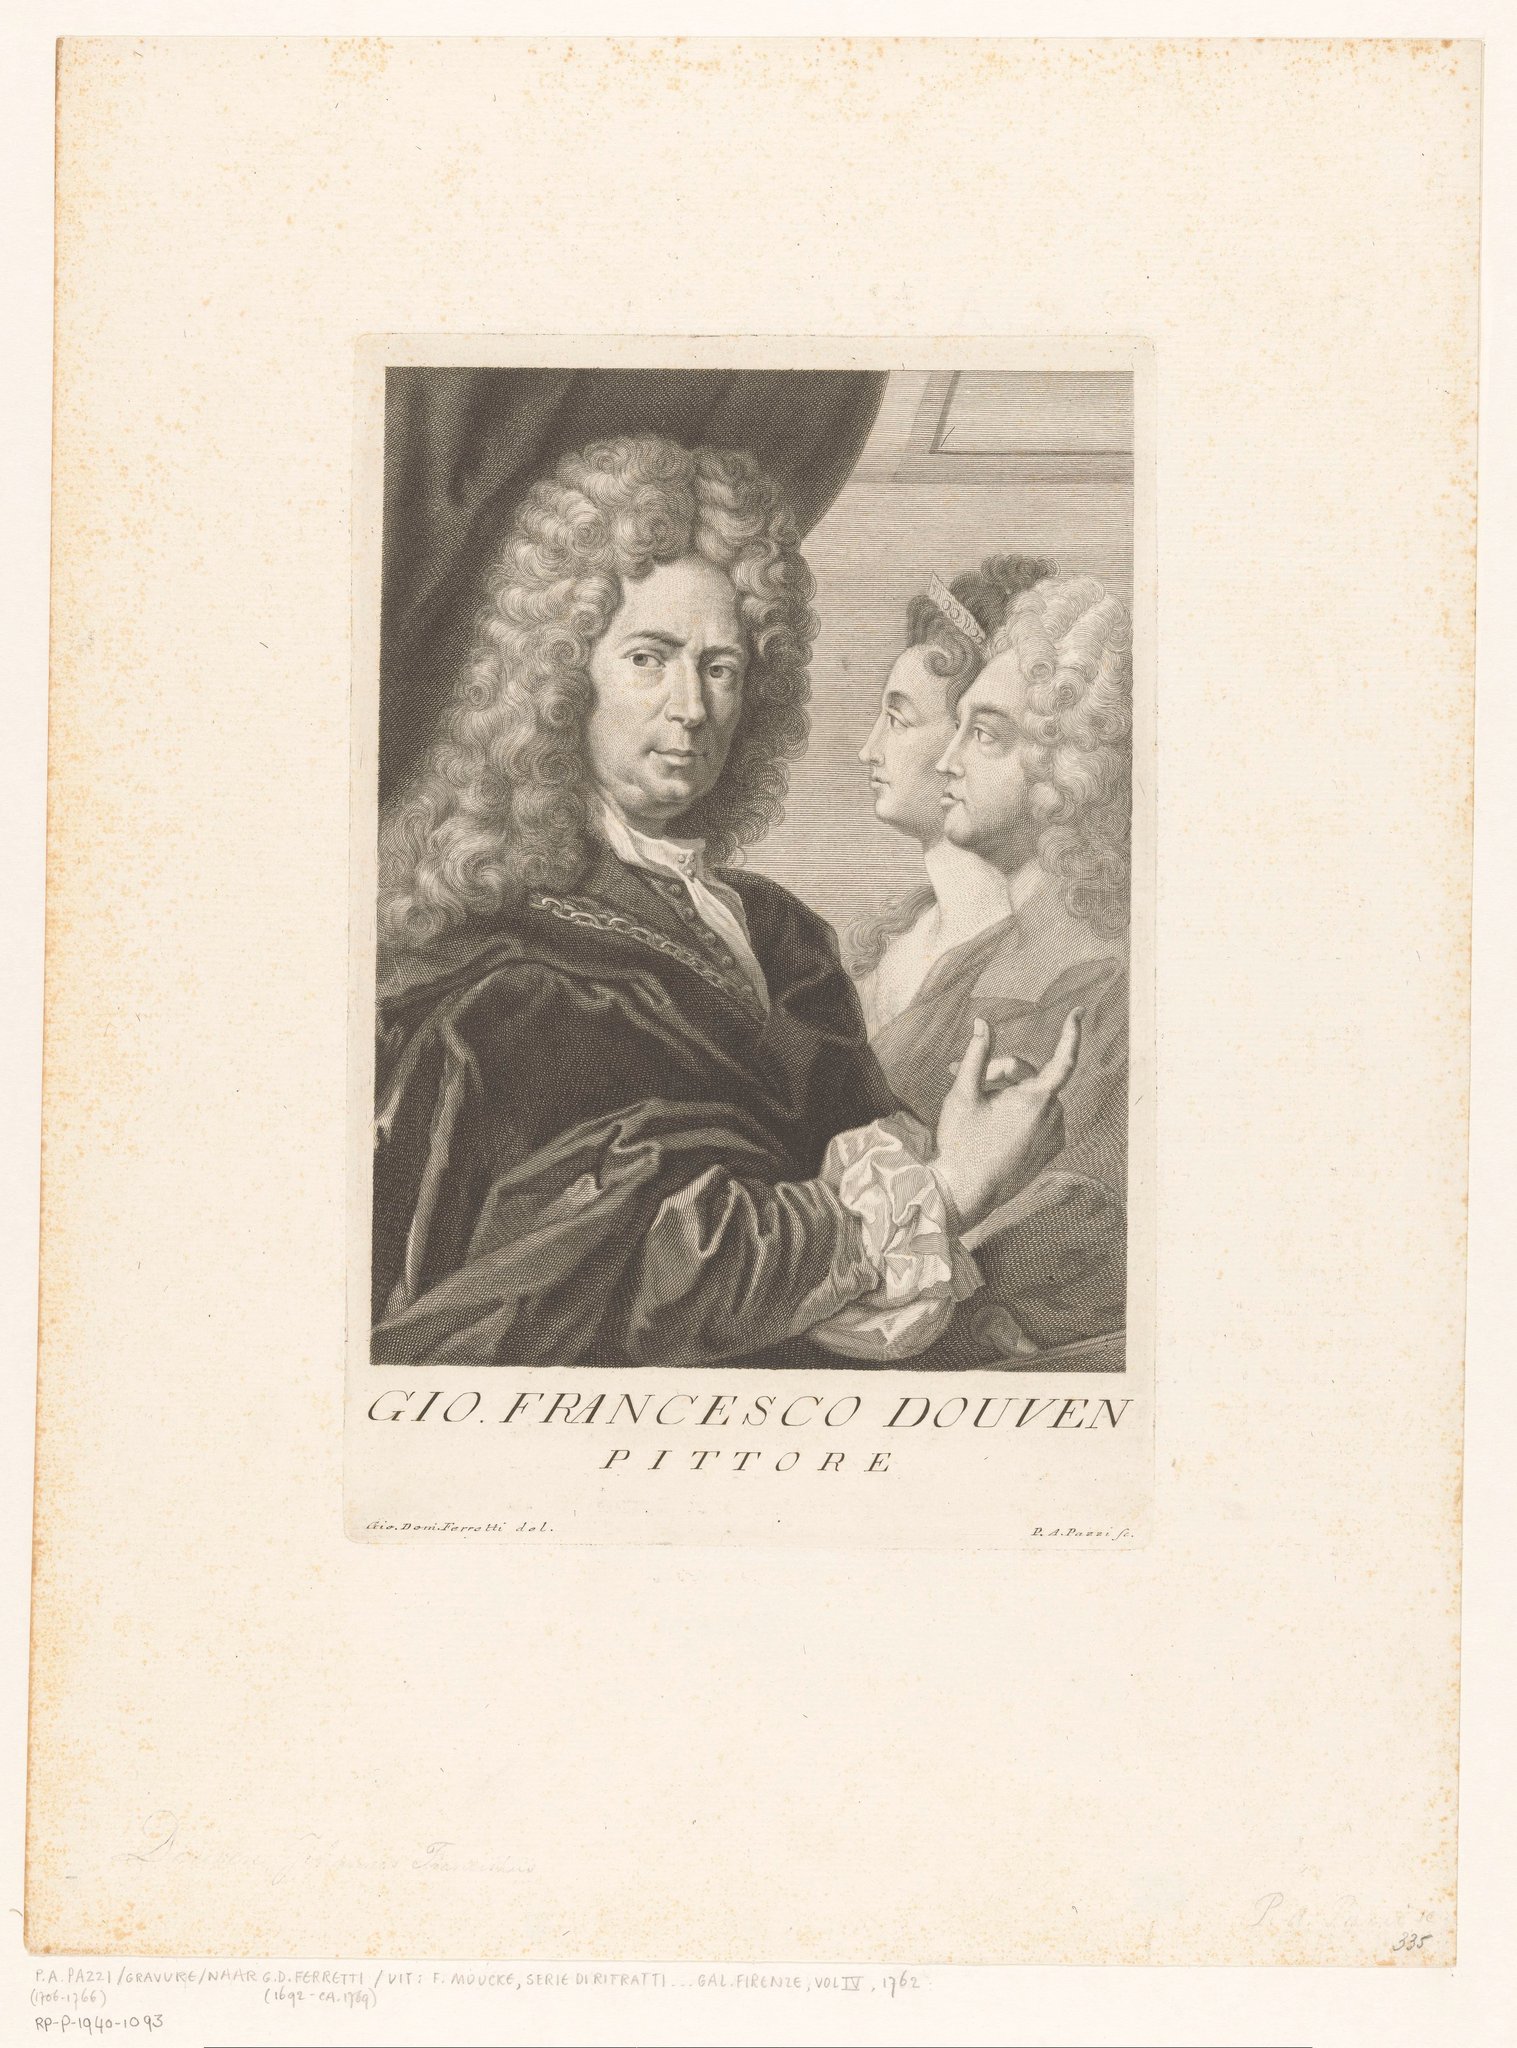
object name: print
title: Portretten van kunstenaars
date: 1752-1762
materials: paper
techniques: engraving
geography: italy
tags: jan frans van douven, historical persons, portrait, self-portrait of artist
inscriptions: collector's mark: Lugt 2760, collector's mark: ‘RIJKS / MUSM’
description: Prent naar geschilderd zelfportret van Jan Frans van Douven in de Galleria degli Uffizi te Florence (inv.nr. 1873). Prent uit: Moücke, Francesco. Serie di ritratti degli eccellenti pittori dipinti di propria mano, che esistono nell'Imiperial Galleria di Firenze. Florence: 1752-1762.